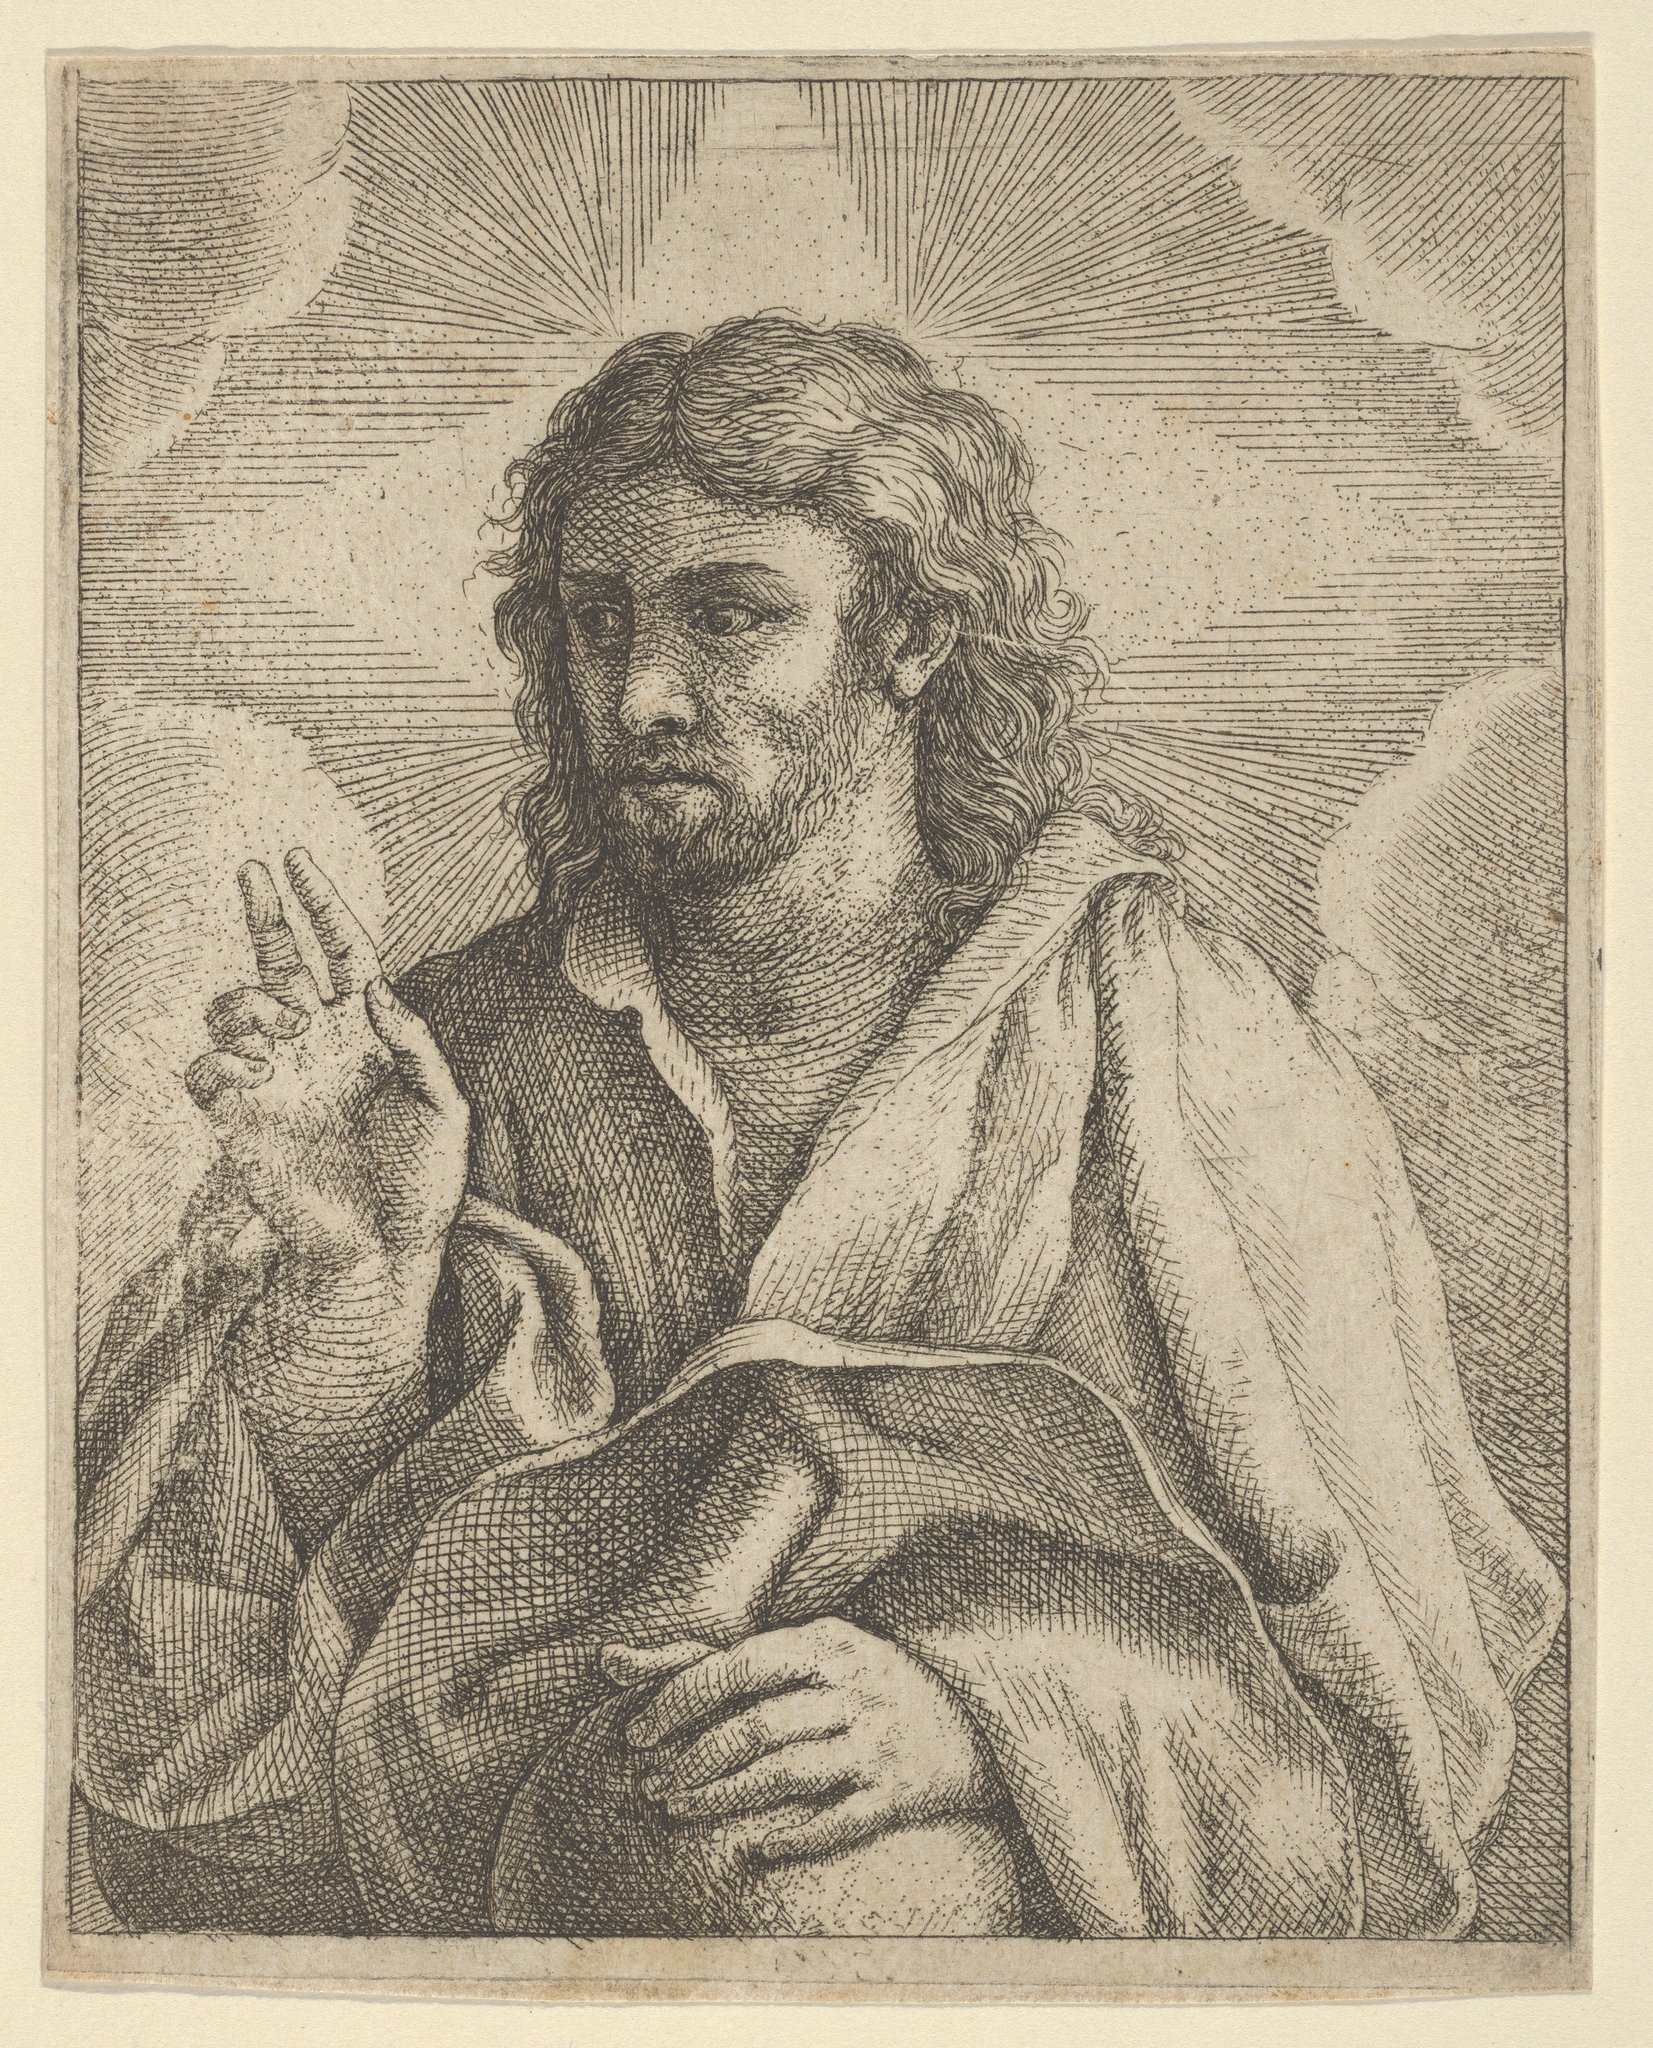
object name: print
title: Christ holding a globe, looking to the left and making the sign of blessing with his right hand, clouds behind him, after Reni (?)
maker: anonymous, 17th century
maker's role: artist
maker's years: 1600-1700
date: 1601-1700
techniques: etching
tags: christ